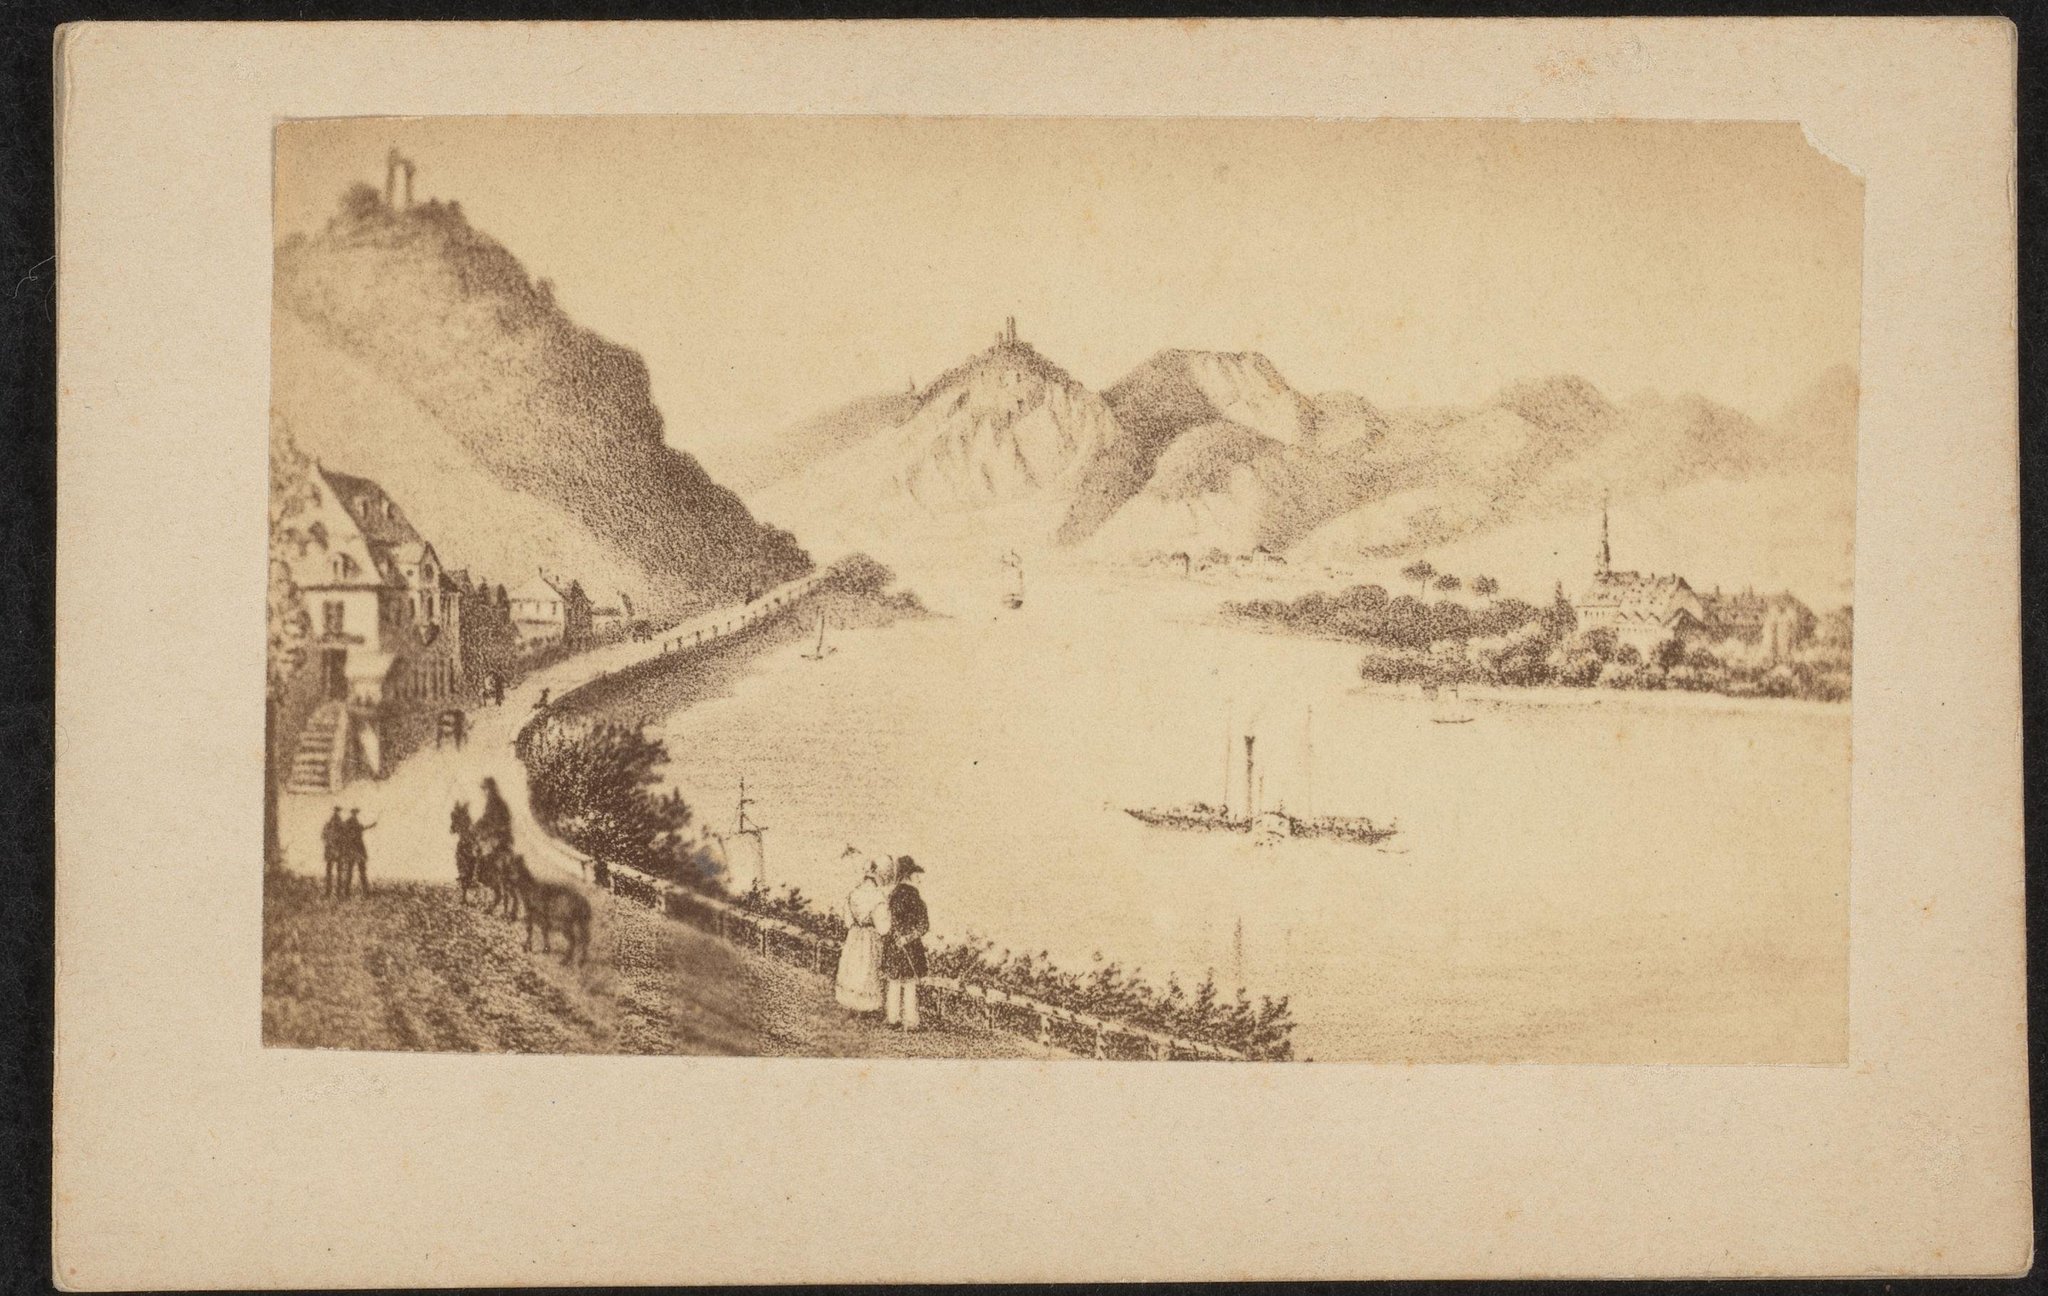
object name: carte de visite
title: Fotoreproductie van een prent van een gezicht op Godesberg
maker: Anonymous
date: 1860-1900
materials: cardboard, photographic support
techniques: albumen print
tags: landscapes, landscape with tower or castle (+ city(-scape) with figures, staffage)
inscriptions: annotation: ‘Godesberg’